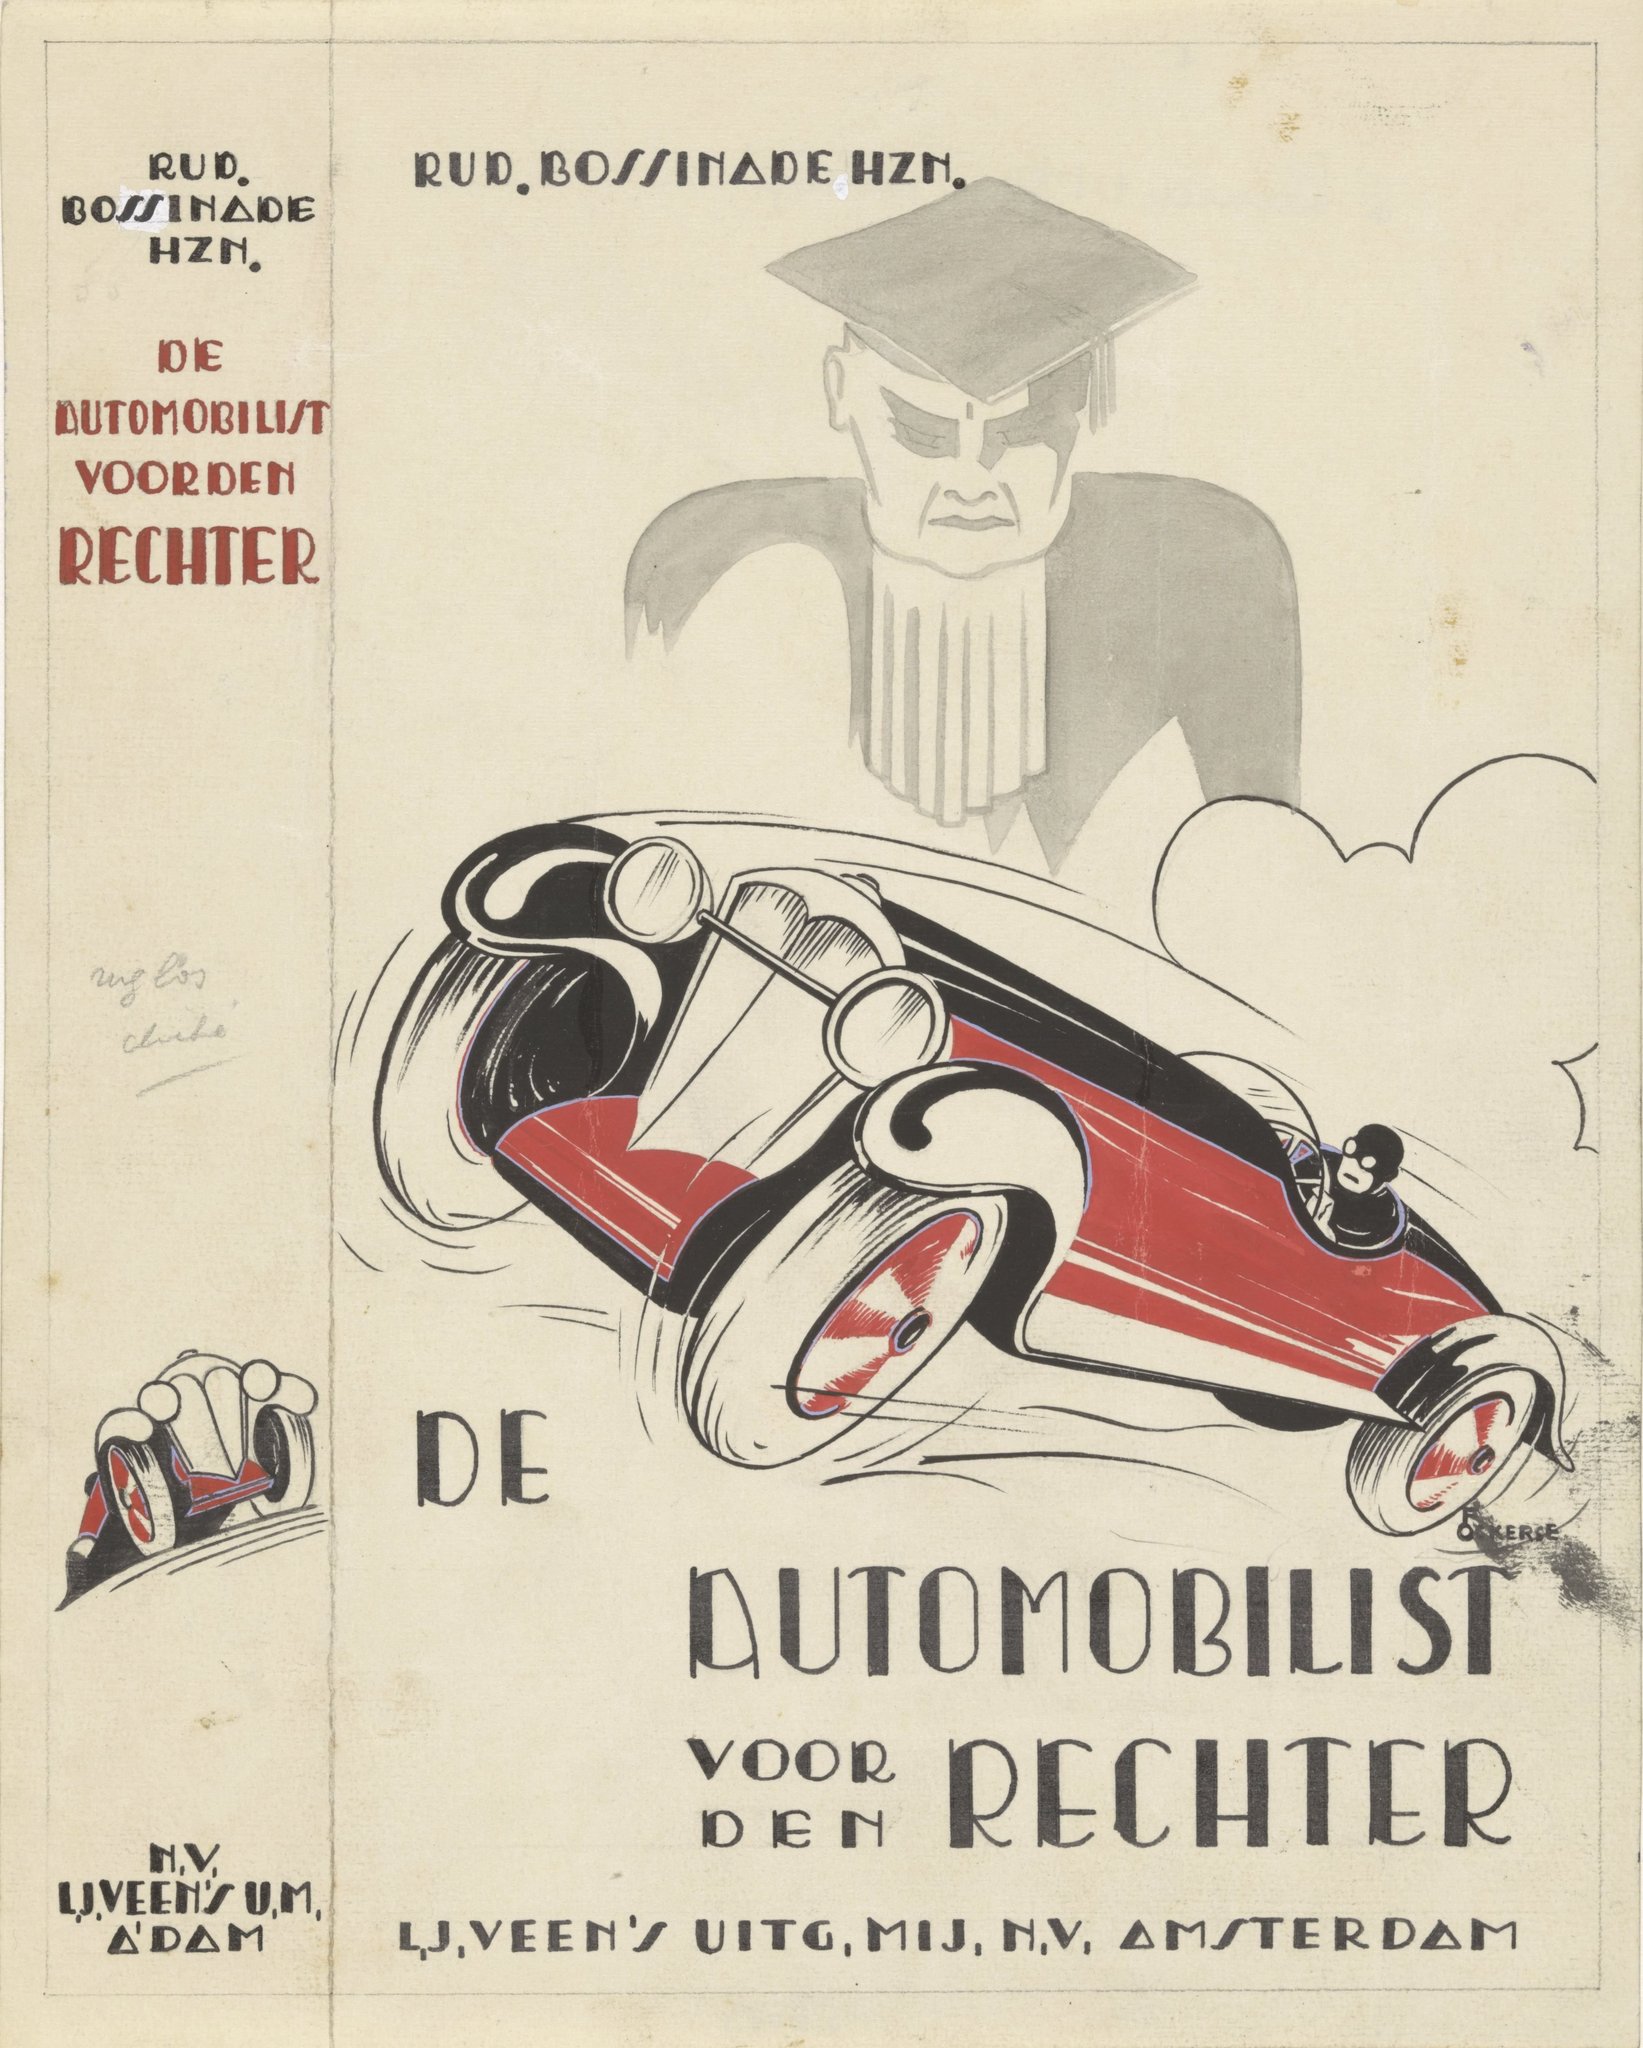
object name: drawing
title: Bandontwerp voor: Rudolf Bossinade, De automobilist voor den rechter: Automobilistenrecht, c. 1932-1934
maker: f. ockerse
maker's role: draughtsman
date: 1932-1934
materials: paint, ink, paper, pencil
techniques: brush, pen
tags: lawyer, attorney at law, automobile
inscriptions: collector's mark: Lugt 2228, signature: ‘F/ OCKERSE’, :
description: Een automobilist scheurt over de weg in een wagen met open dak. Boven de auto een rechter in een toga met bef. Op de boekrug een vooraanzicht van de auto.